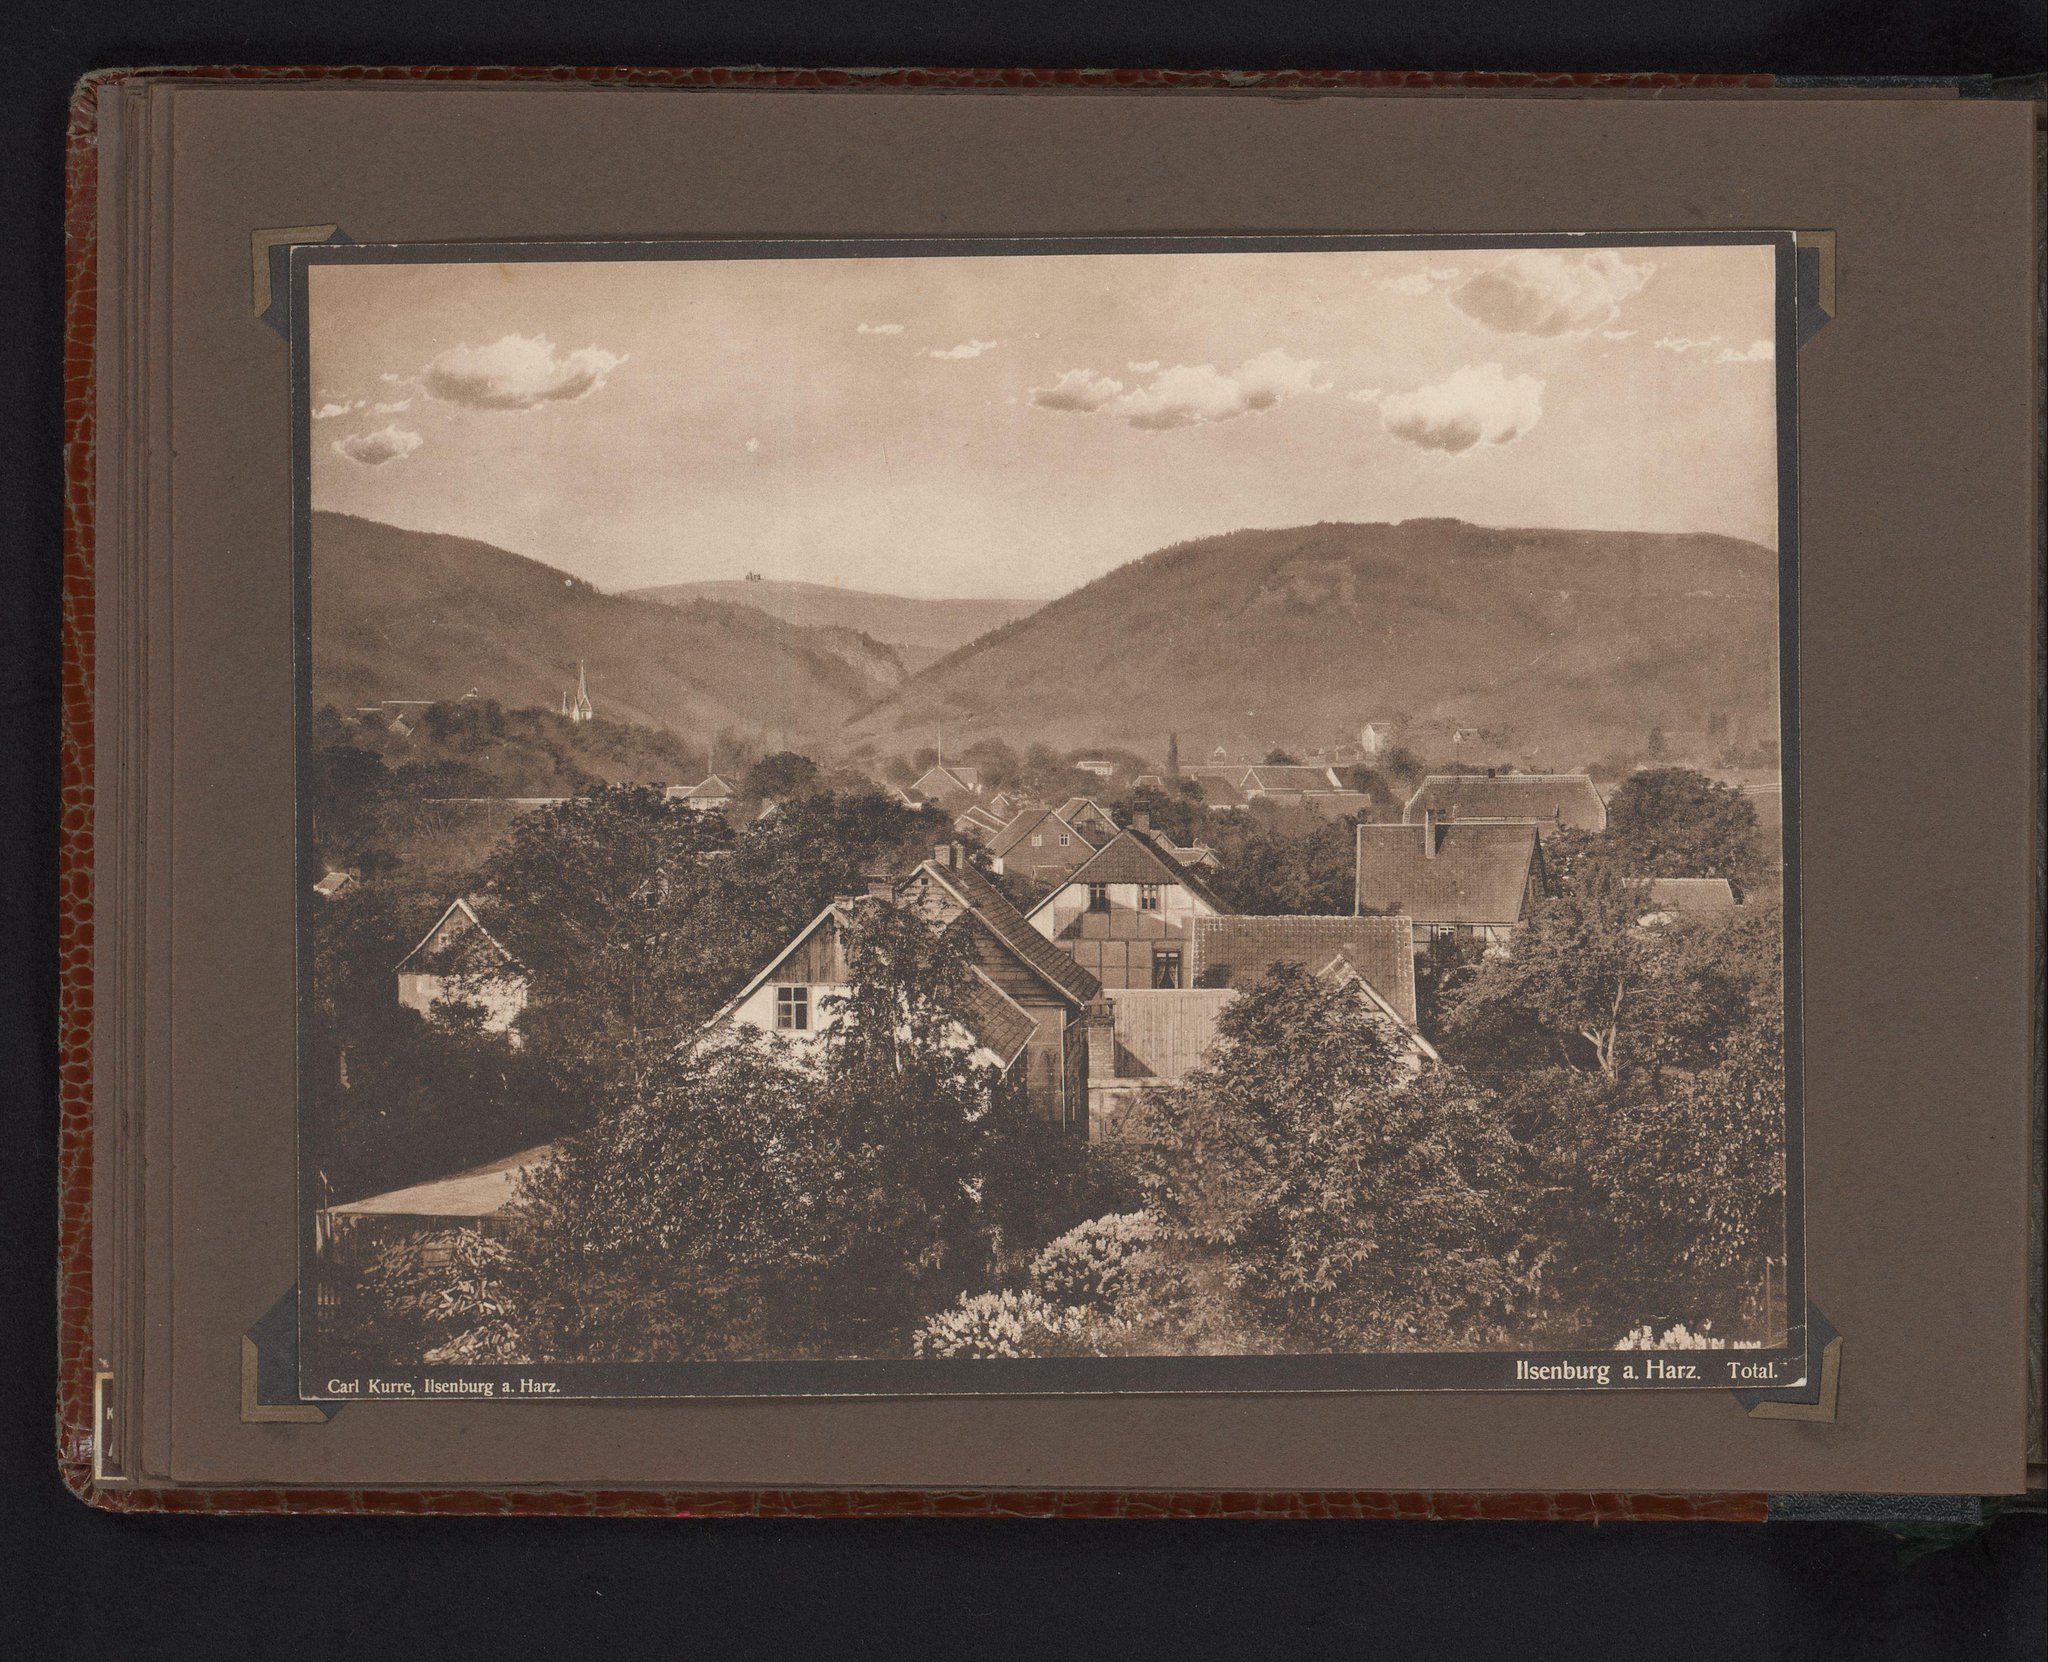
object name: photomechanical print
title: Ilsenburg a. Harz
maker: carl kurre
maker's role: fotograaf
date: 1925-1940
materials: paper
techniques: photograph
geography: ilsenburg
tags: city-view in general; 'veduta', mountains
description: Deze pagina maakt deel uit van een album.